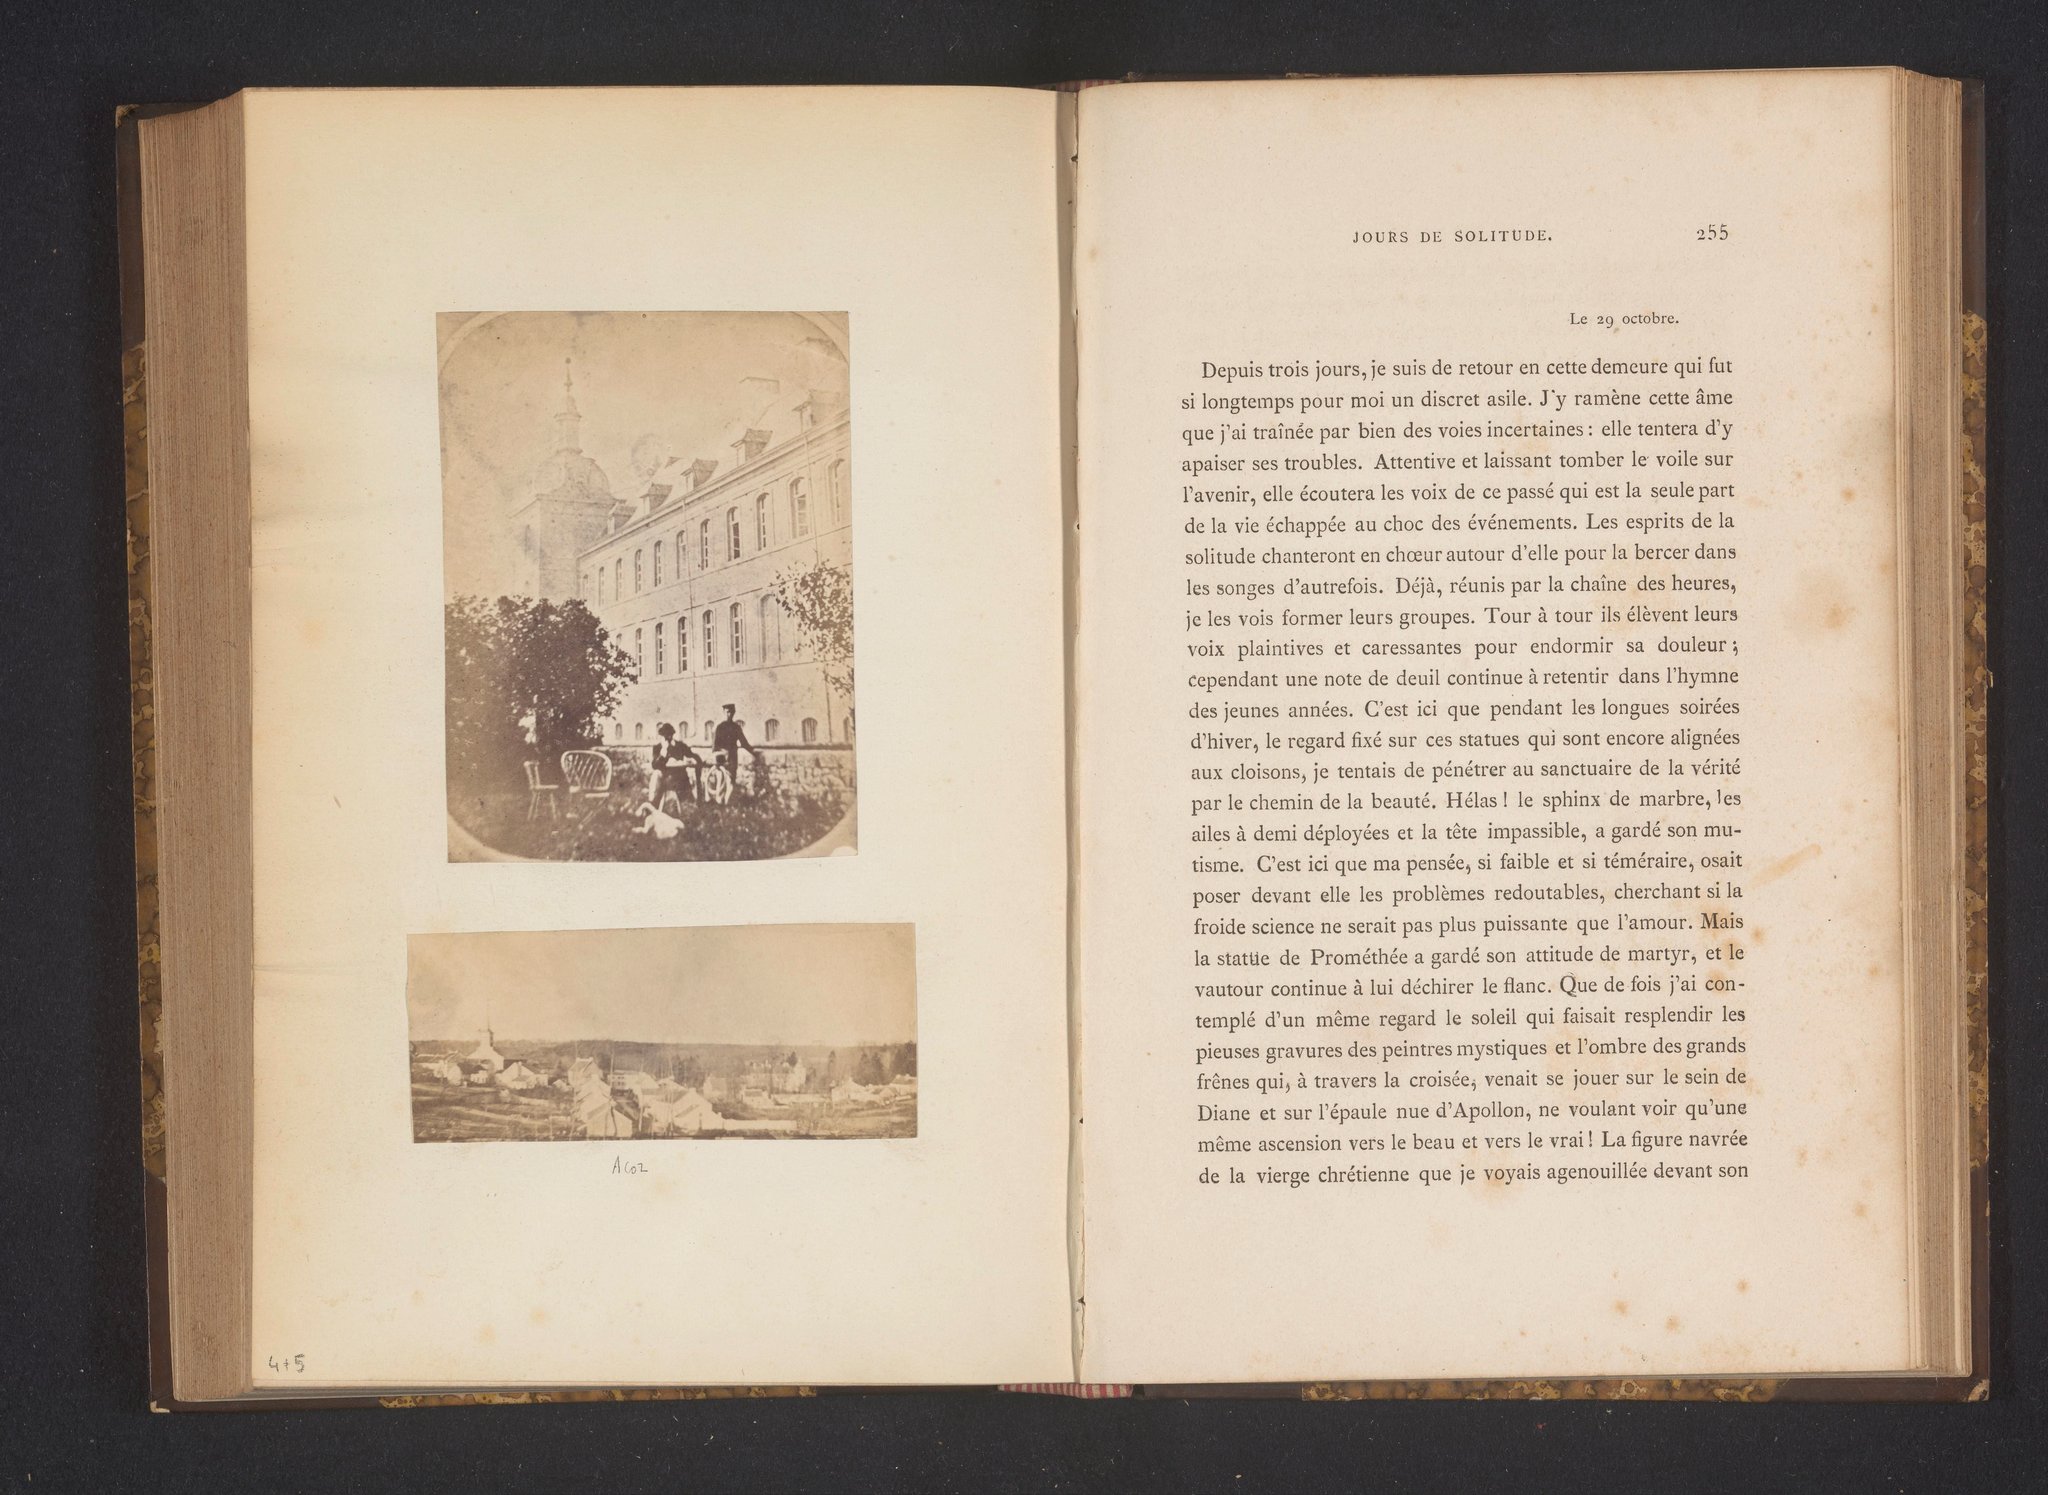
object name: page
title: Gezicht op een dorp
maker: Anonymous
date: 1872-1877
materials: photographic support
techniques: albumen print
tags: roof (of house or building), city-view in general; 'veduta', belgium